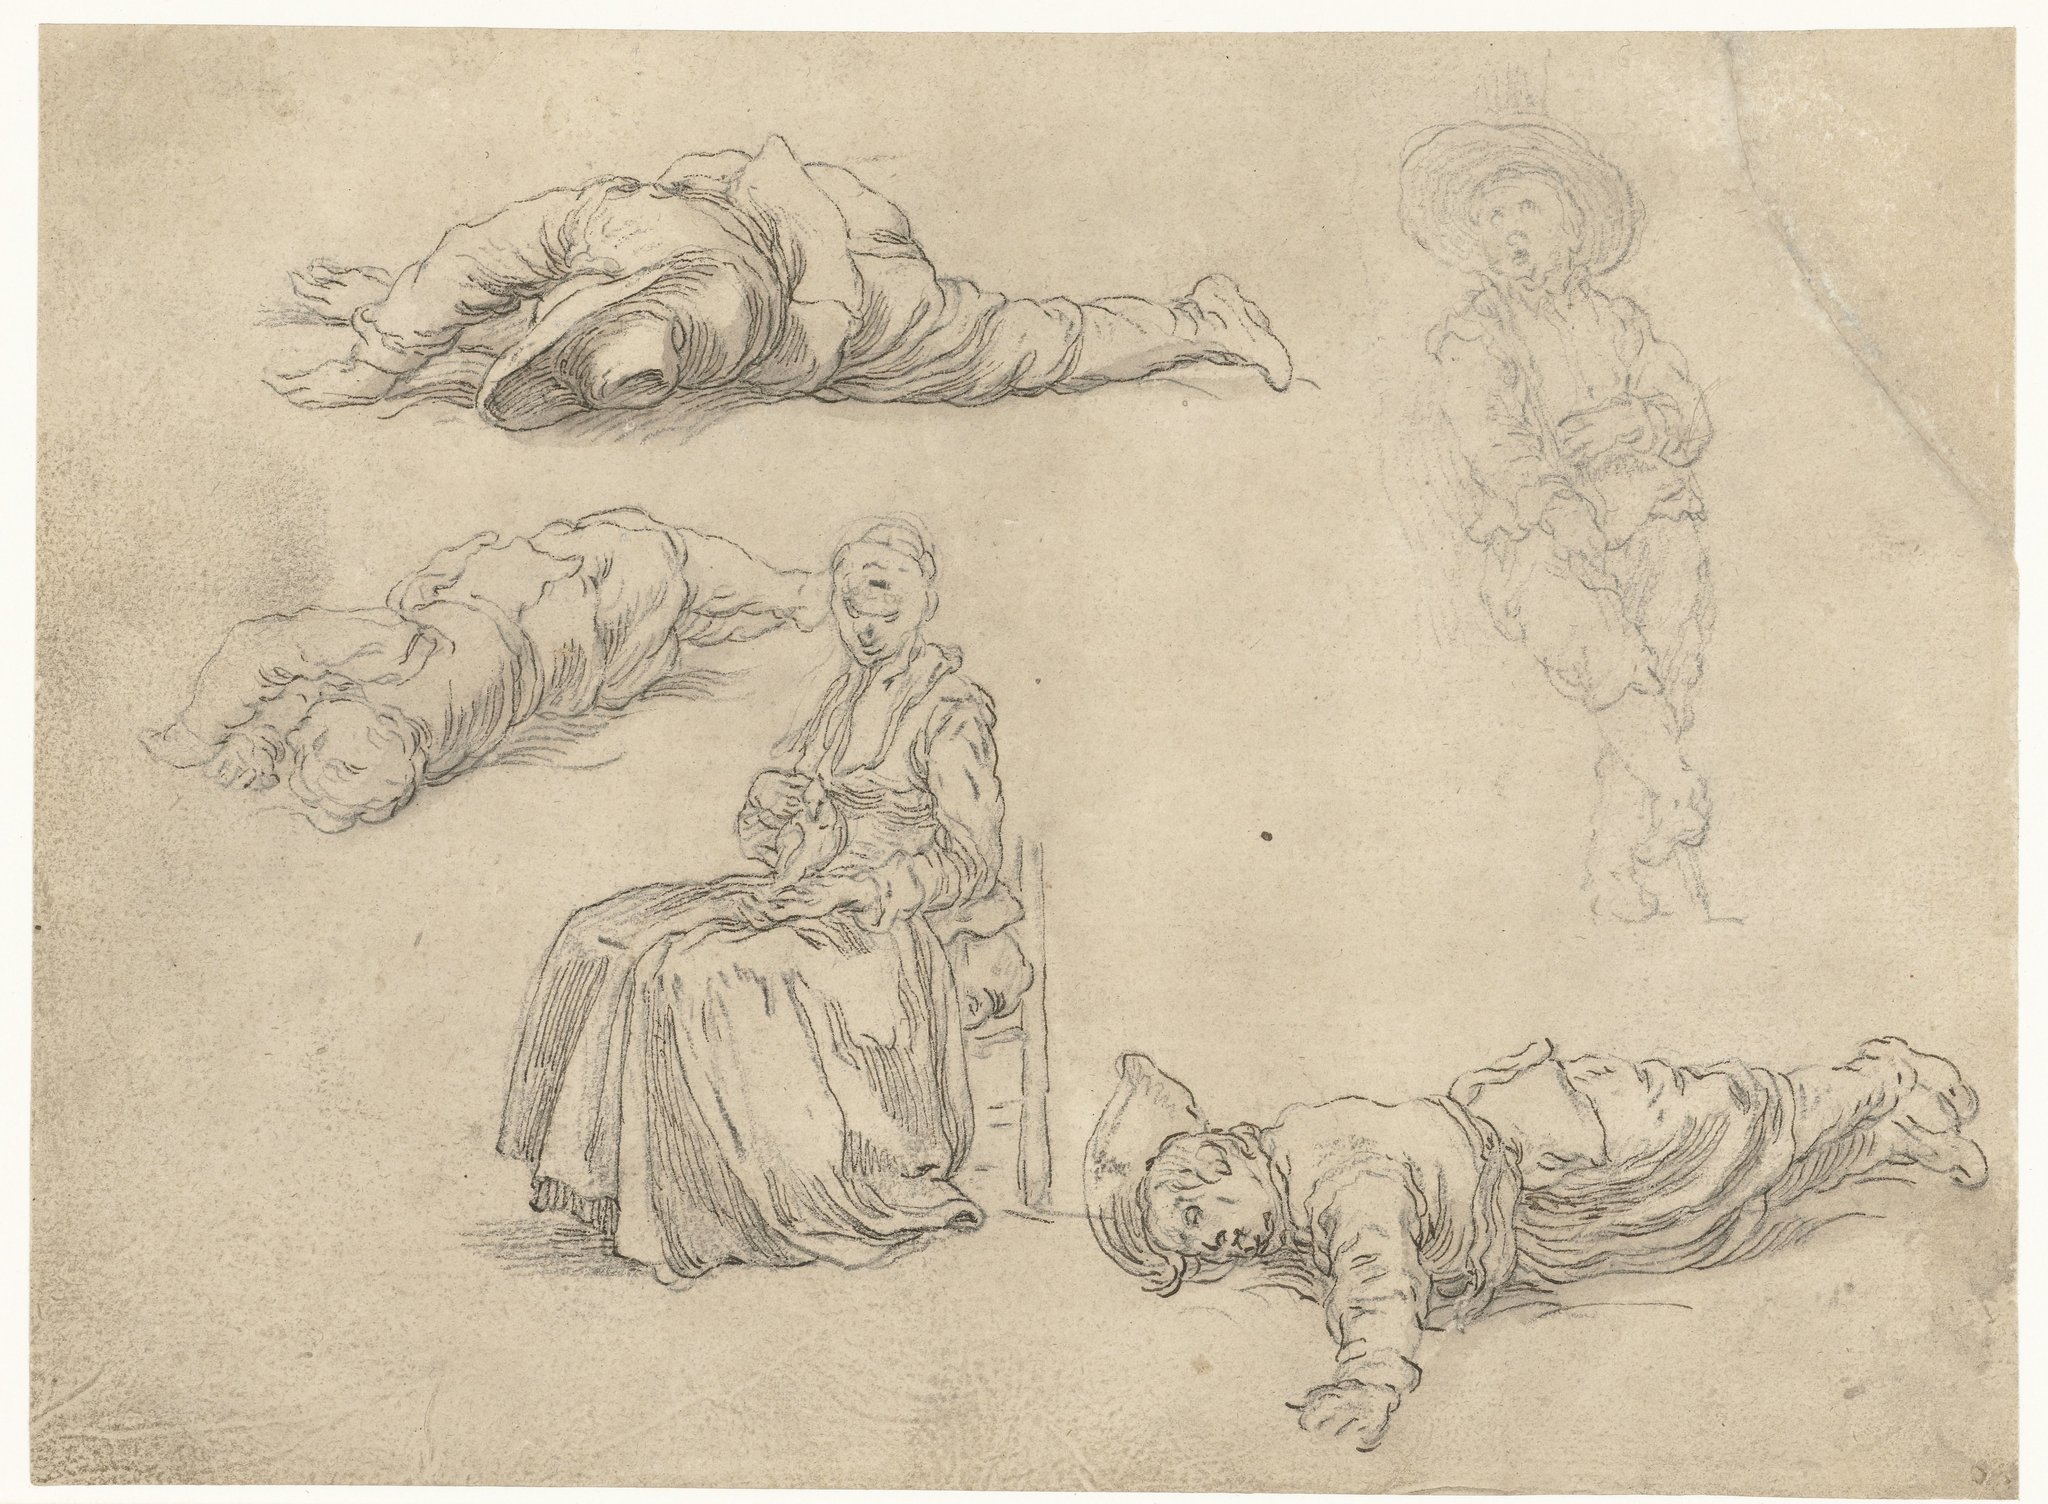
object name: drawing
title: Zittende vrouw met duif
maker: abraham bloemaert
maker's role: draughtsman, painter, print maker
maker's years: 1566-1651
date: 1625-1629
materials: chalk, ink, paper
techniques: pen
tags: sitting figure - aa - female human figure, lying figure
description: Afkomstig uit een schetsboek van 43 (?) bladen.